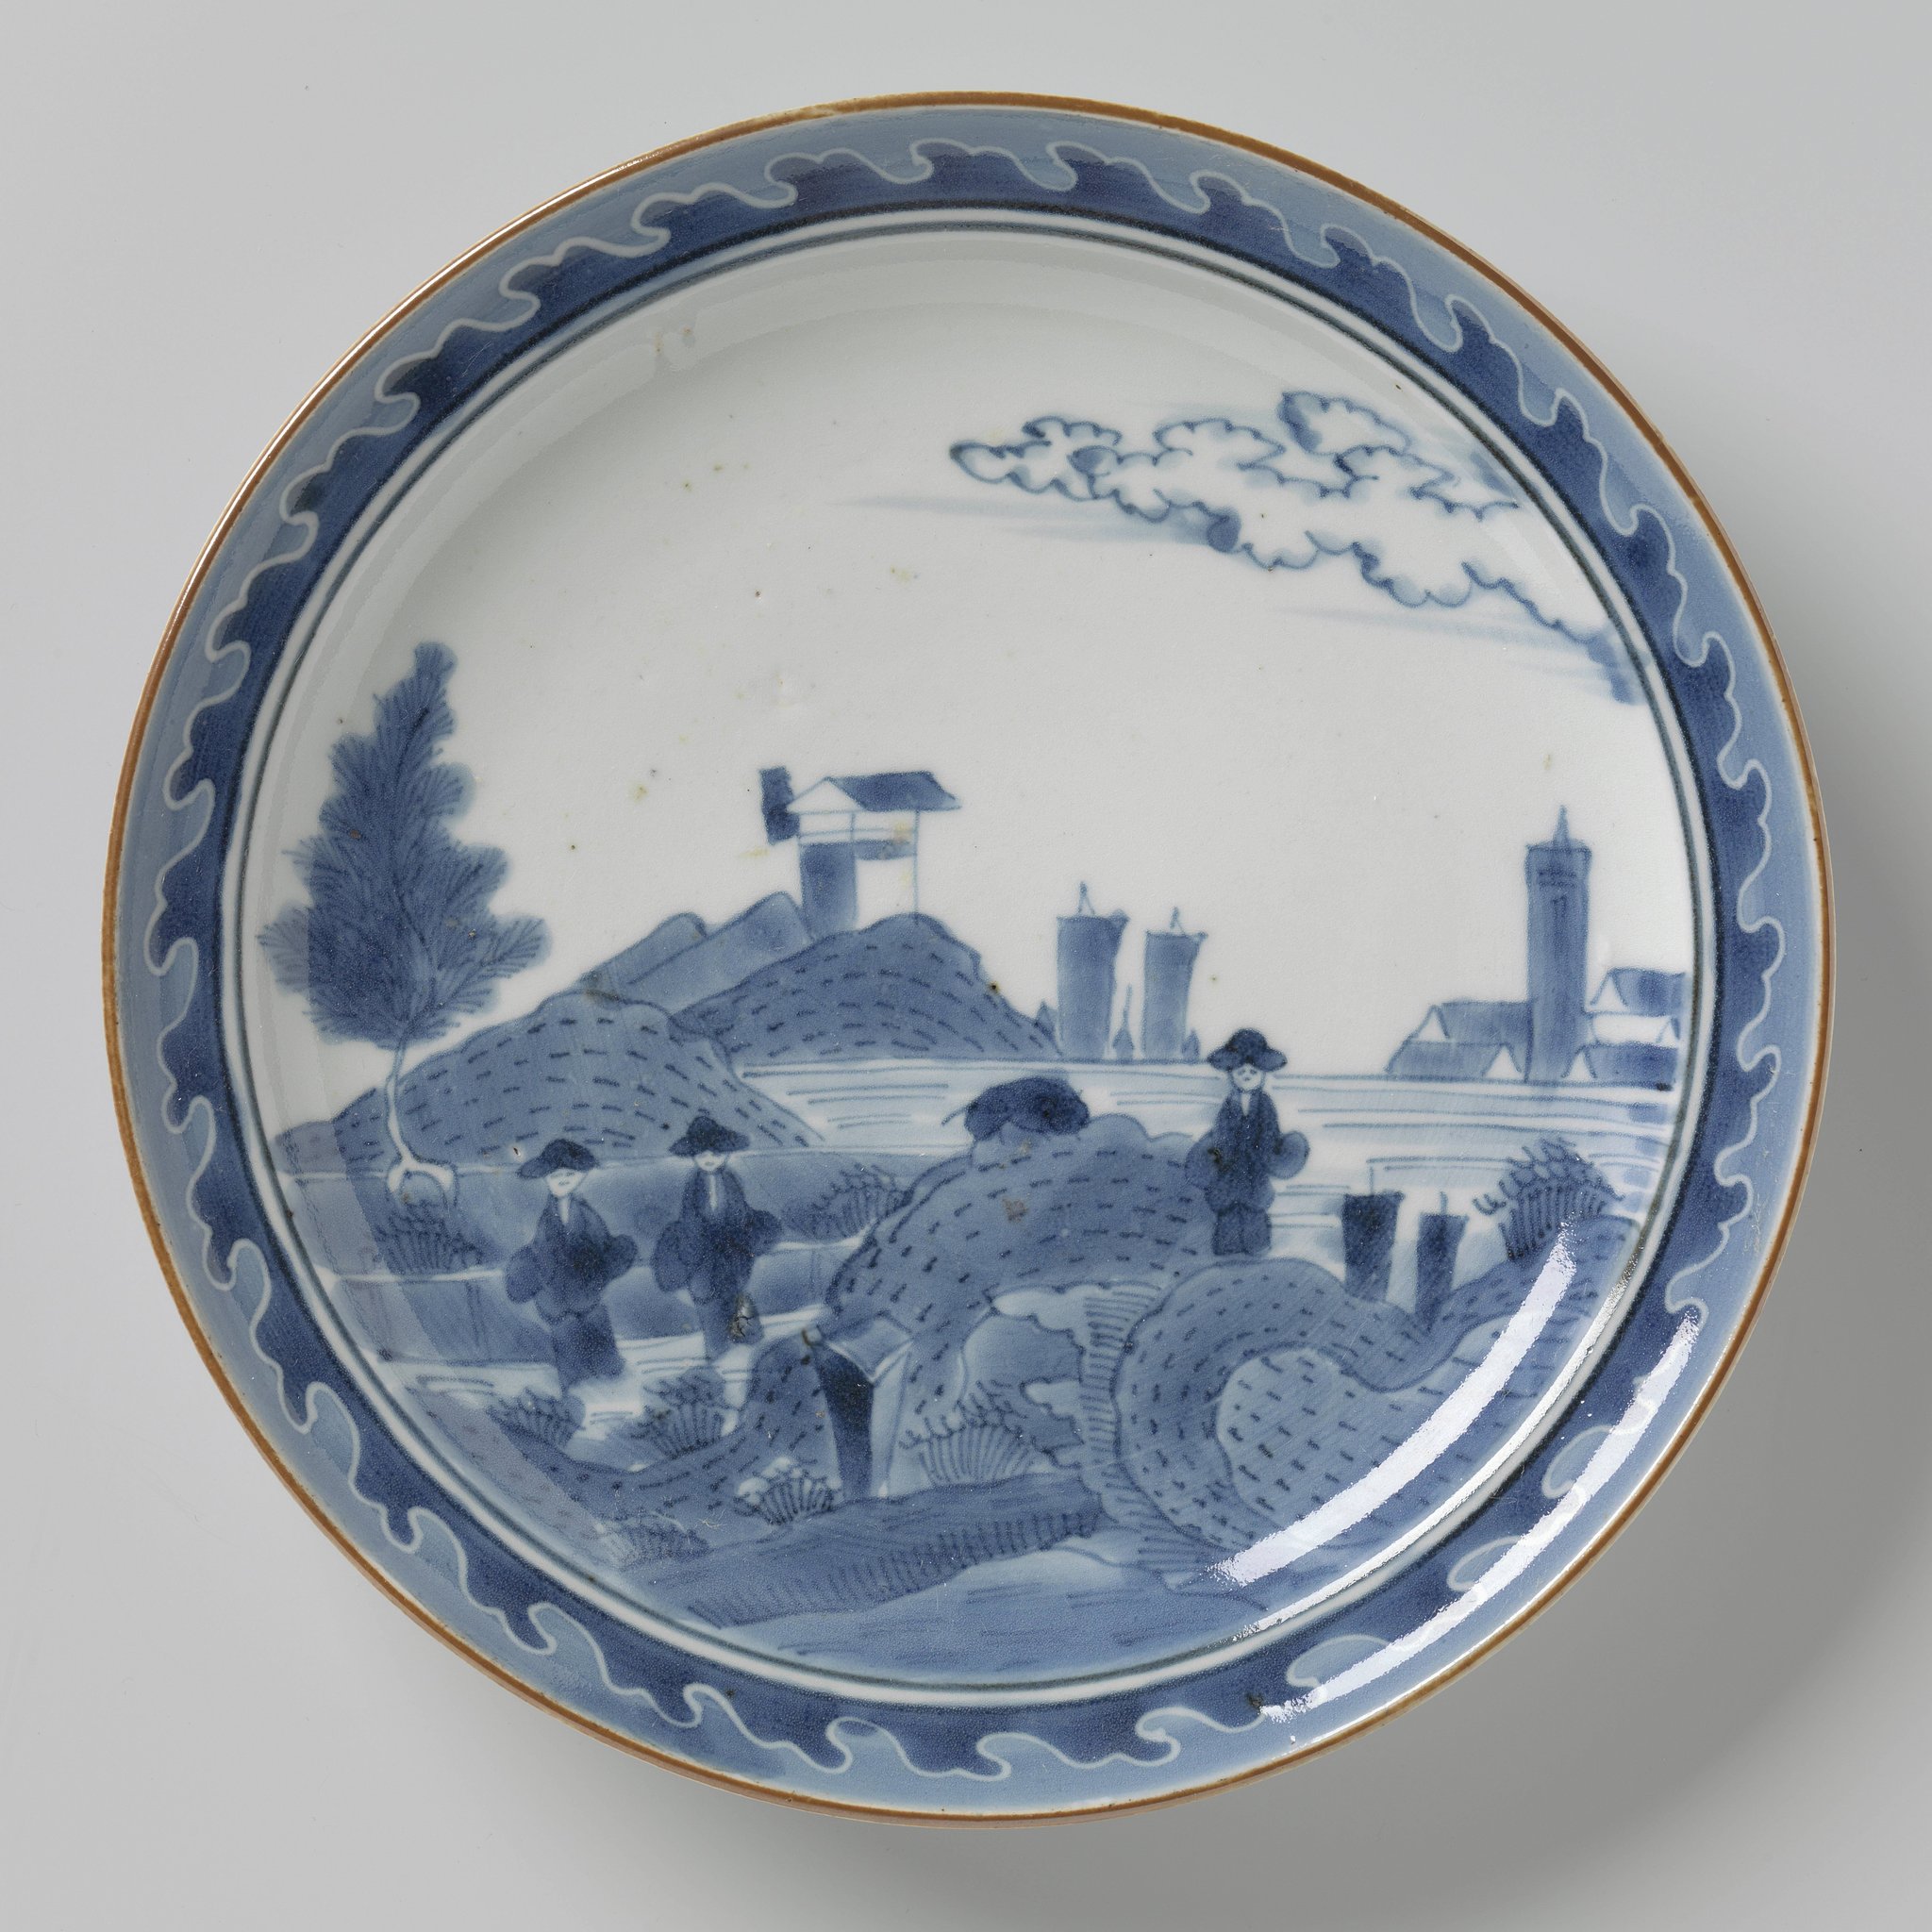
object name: plate dish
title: Two Dishes and a Plate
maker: Anonymous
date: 1600-1699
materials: cobalt, glaze, paint, porcelain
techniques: firing, turning, vitrification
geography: arita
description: Landscapes with European-looking figures and buildings appear in many variations on Japanese export porcelain meant for the European market. They were probably based on Dutch prints, or Delftware, which may explain why the clouds are depicted in a European manner.